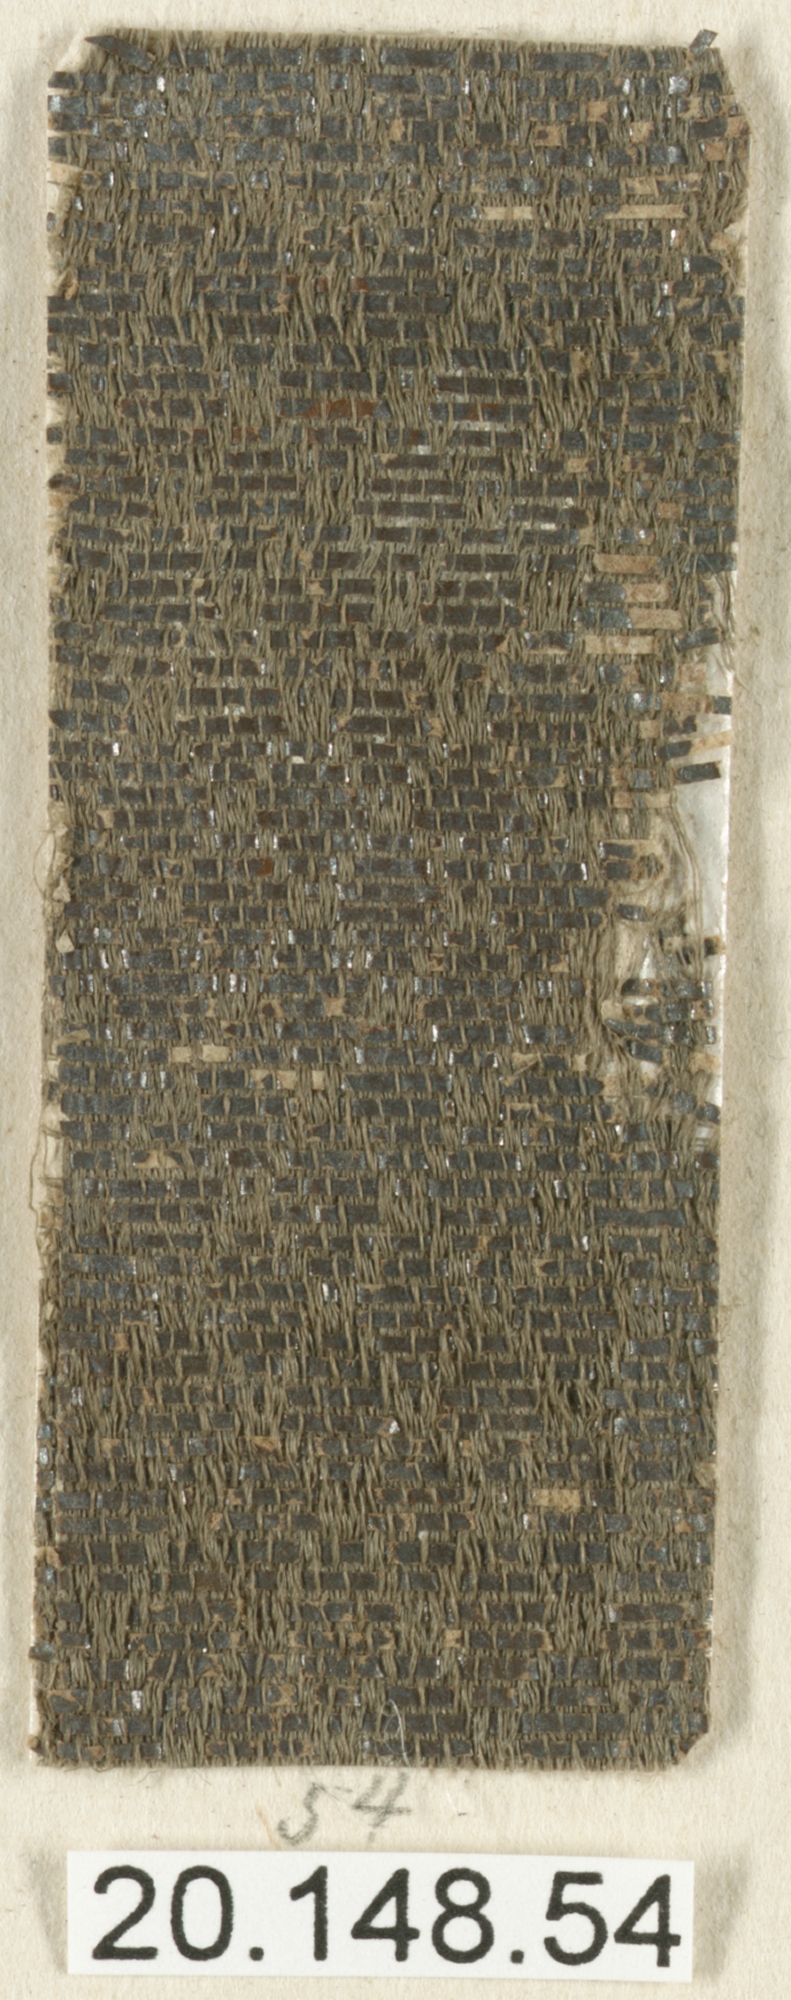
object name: piece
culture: japanese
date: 1501-1600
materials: silk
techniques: compound weave